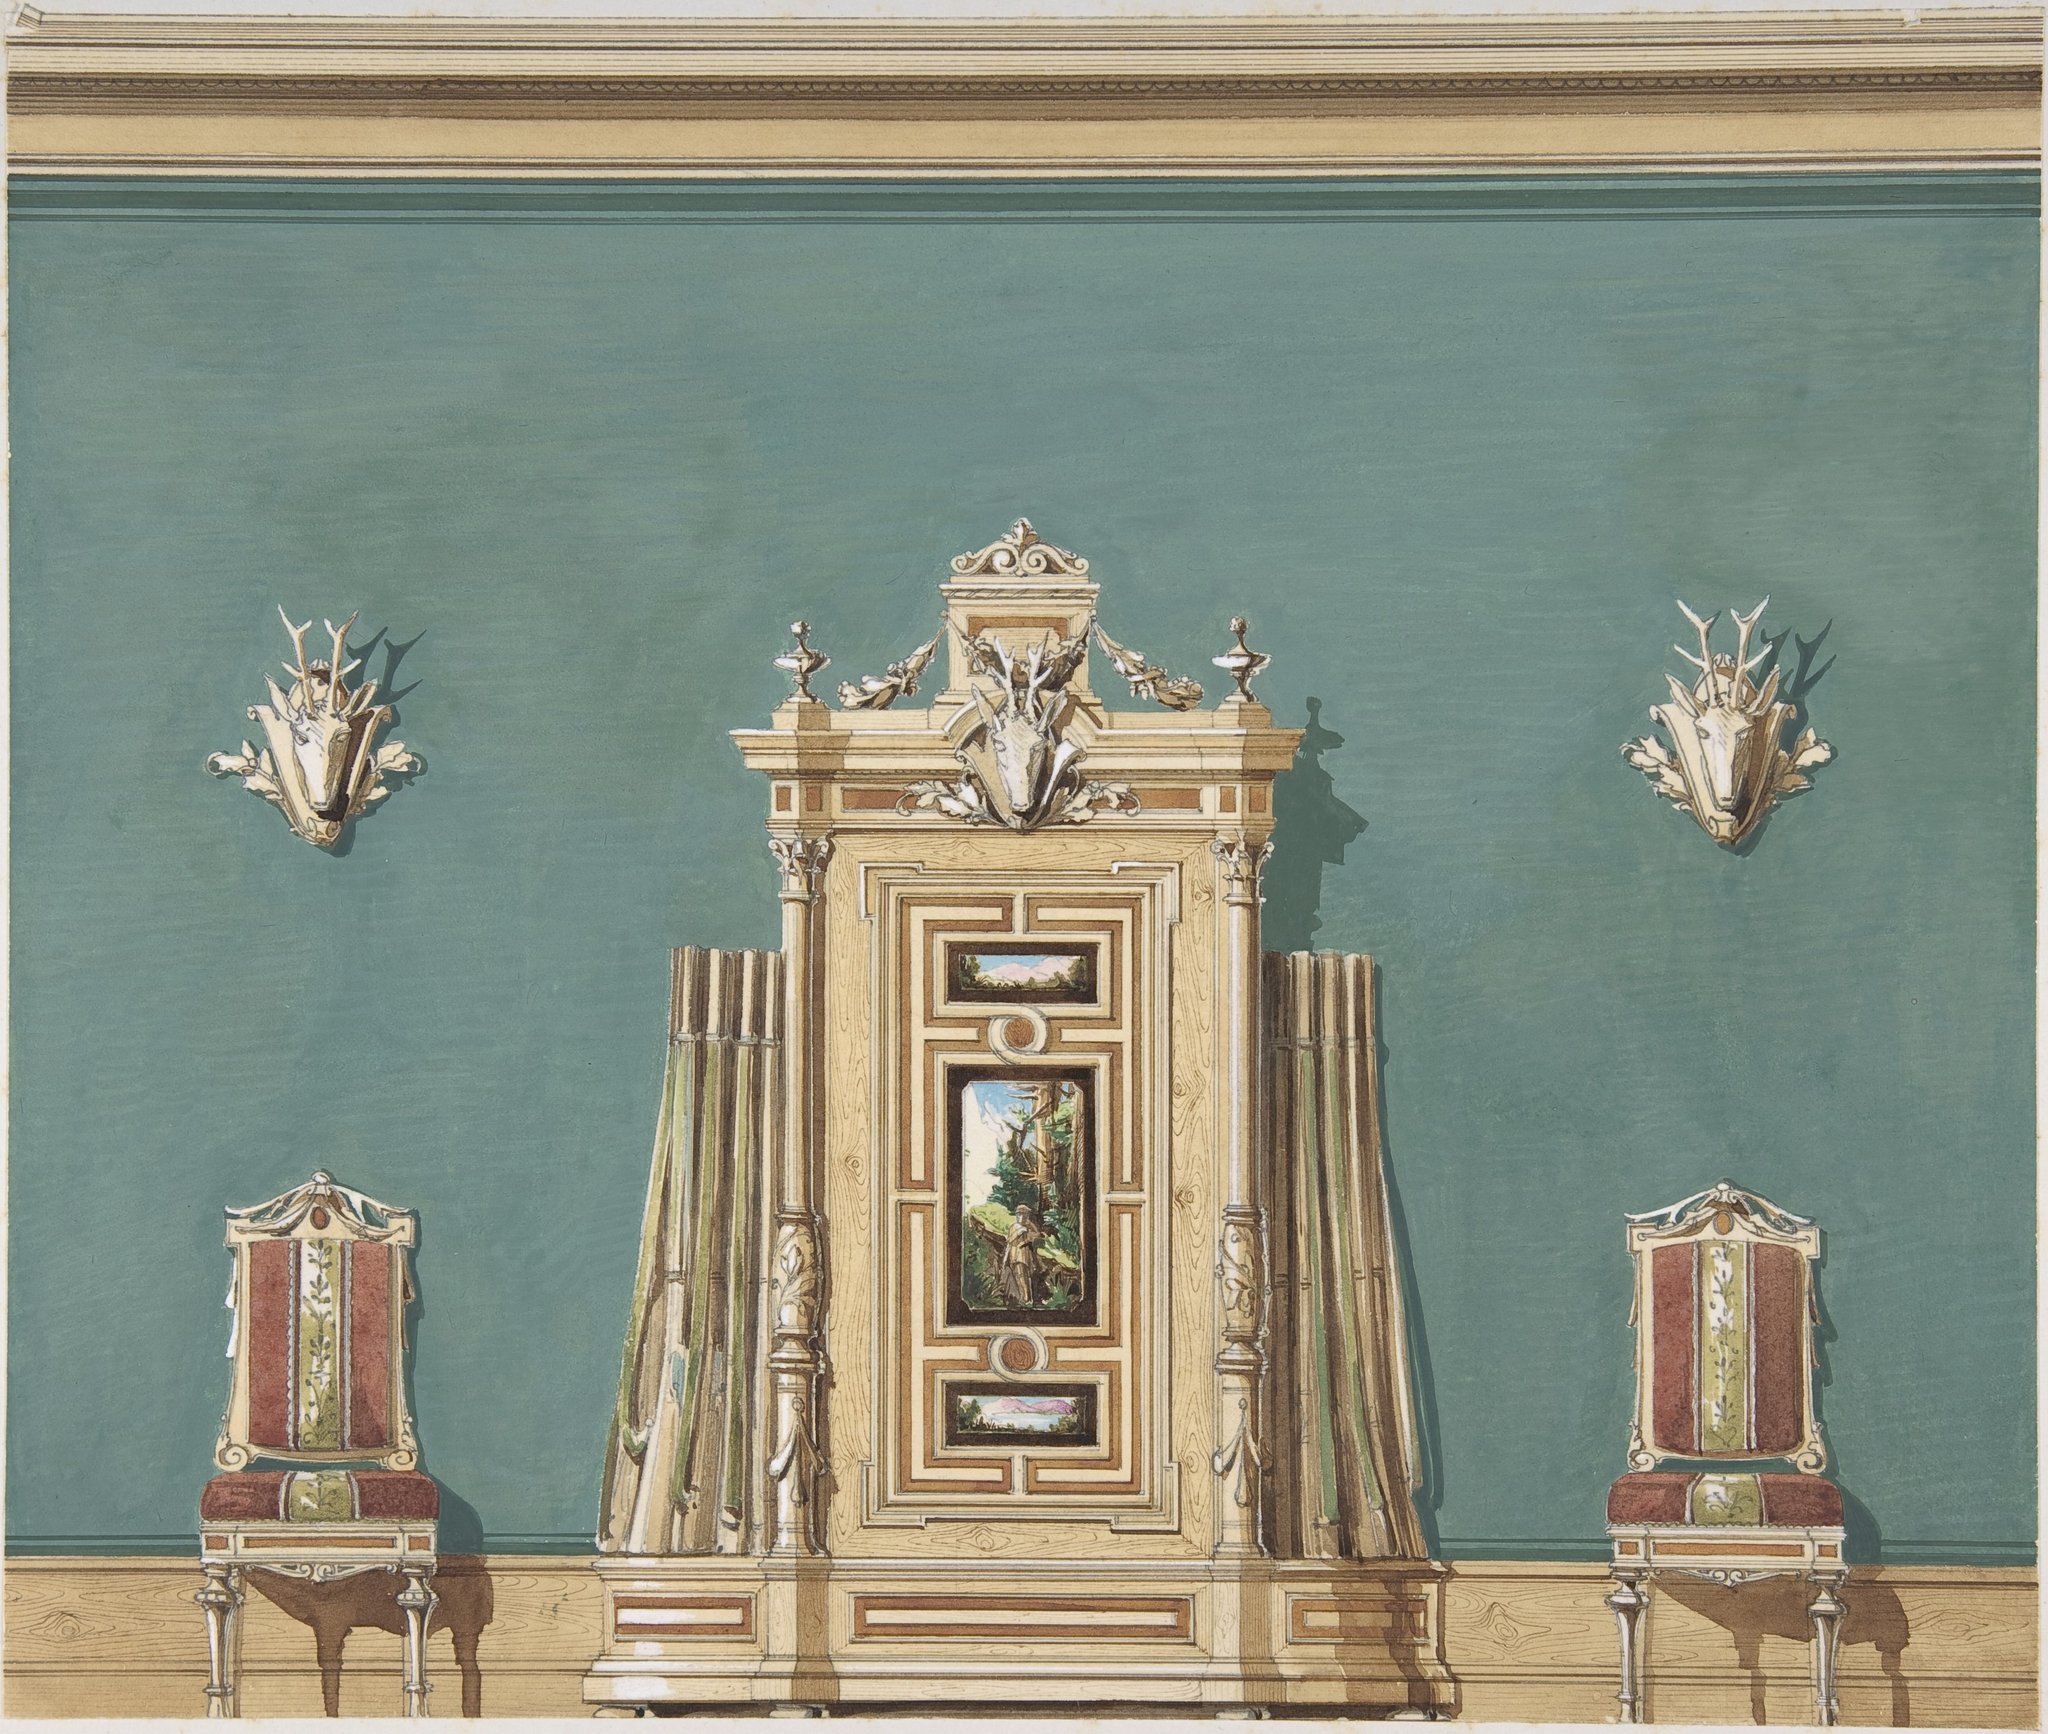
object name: drawing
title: Interior Design witha Gun Cabinet and Two Chairs against a Green Wall Adorned with Trophies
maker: anonymous, british, 19th century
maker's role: artist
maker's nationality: british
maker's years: 1800-1900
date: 1867-1900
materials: gouache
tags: interiors,chairs,cabinets